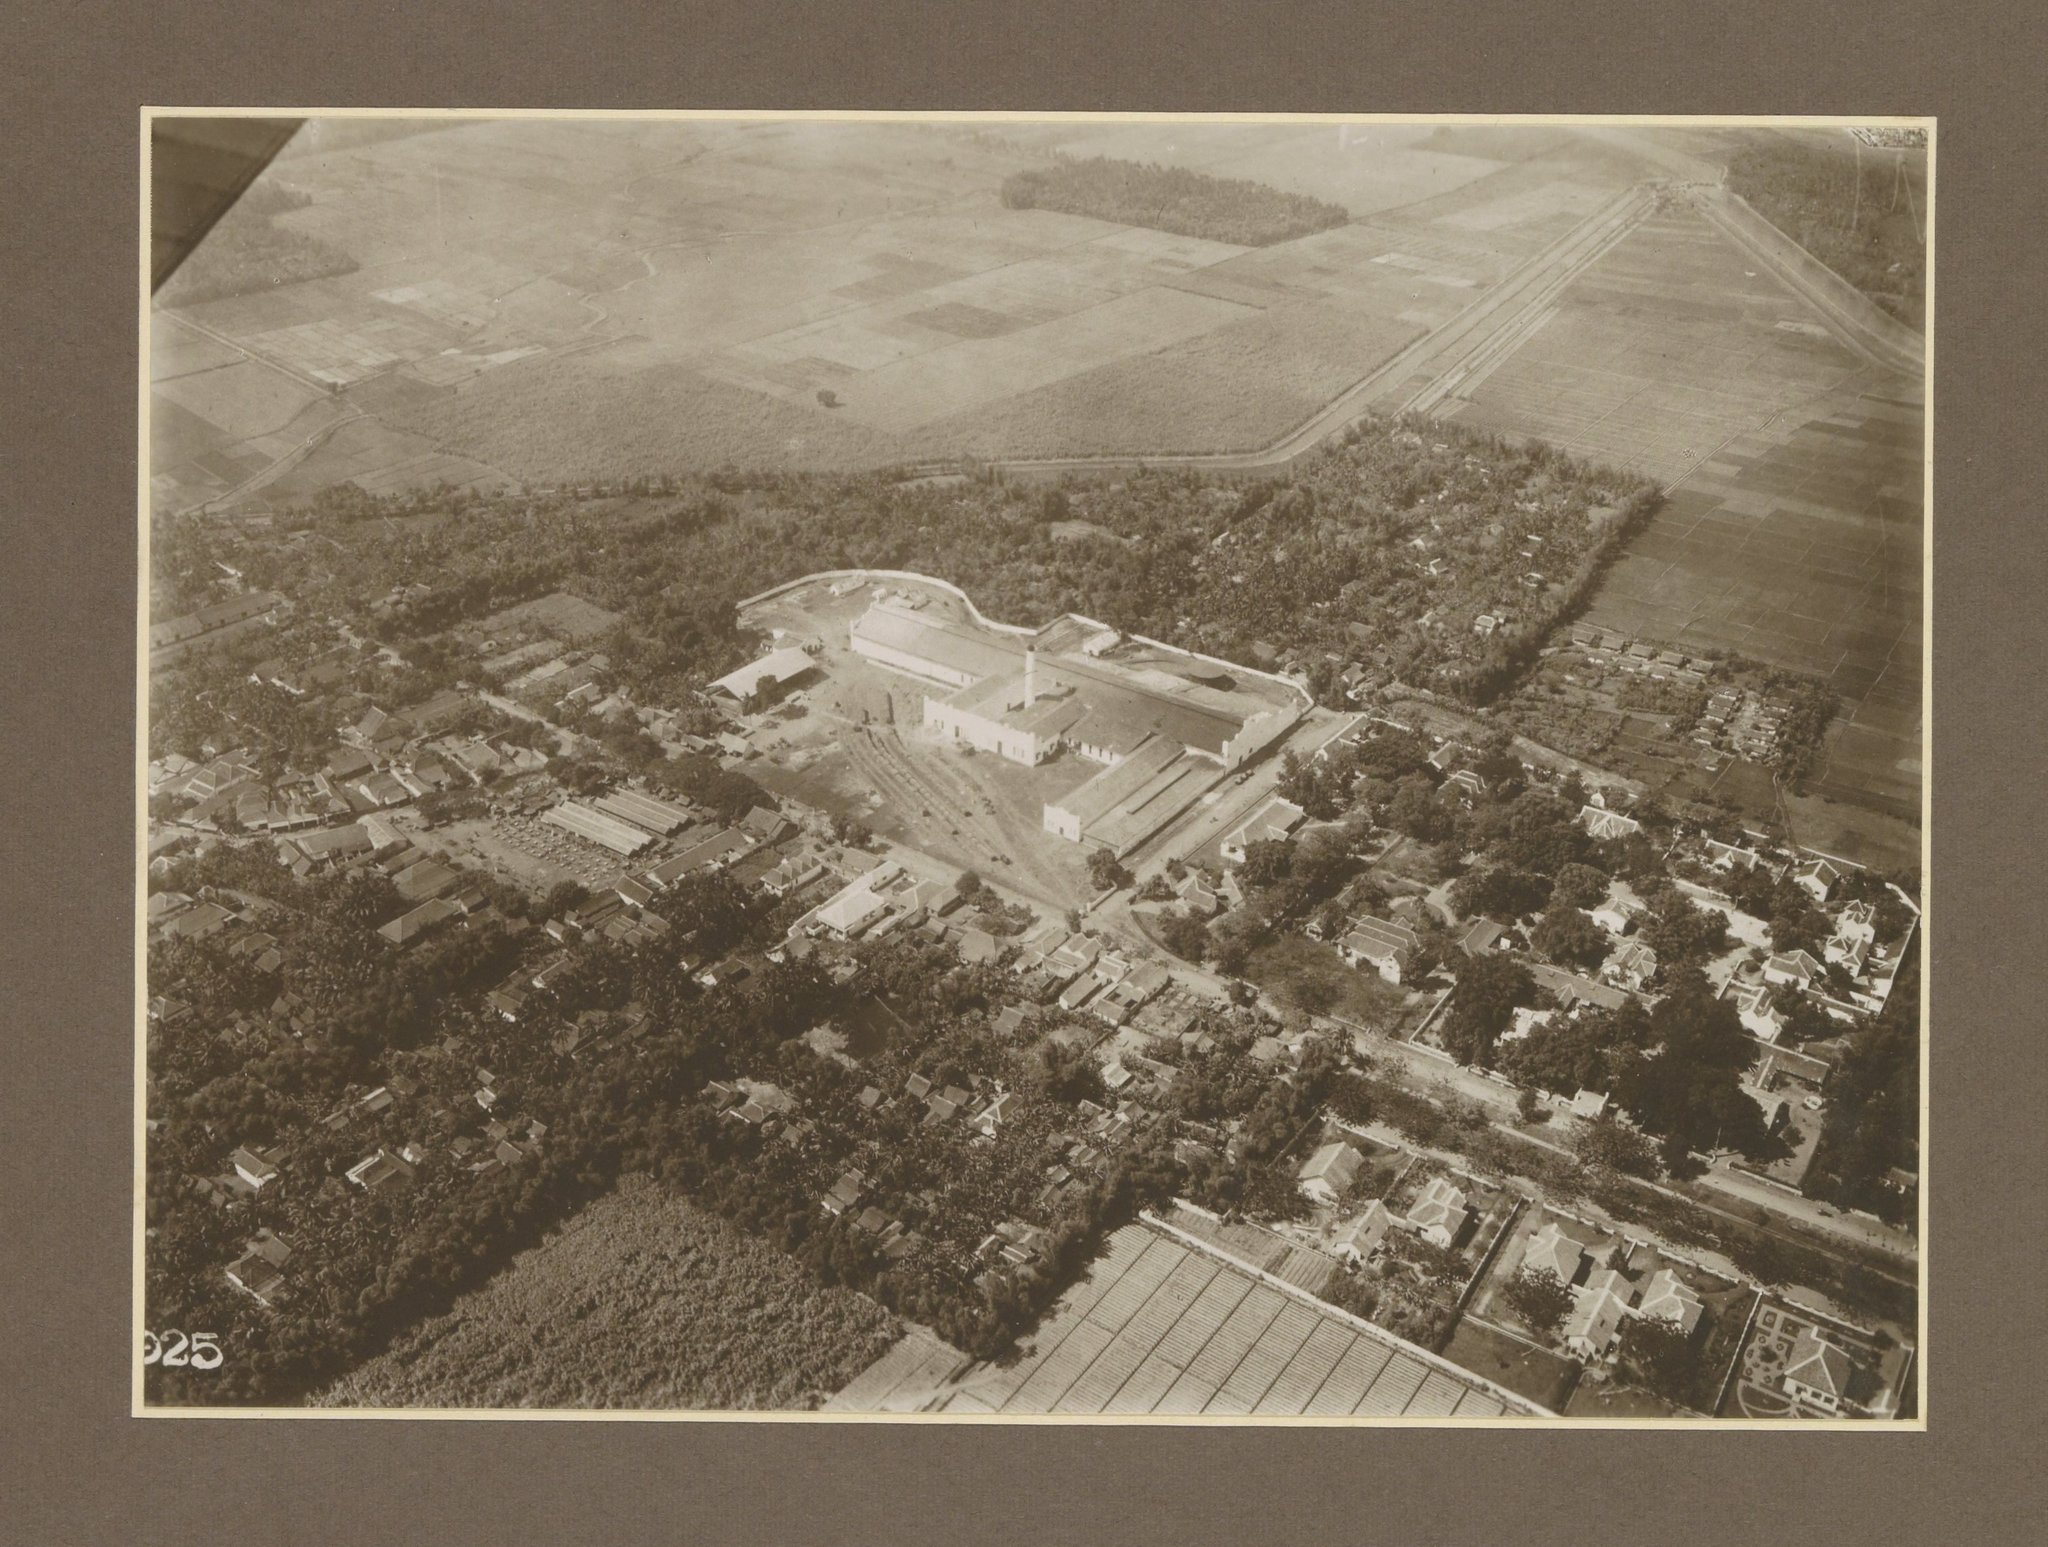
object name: aerial photograph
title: Luchtaanzicht van suikerfabriek Goedo te Djombang op Java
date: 1925-1930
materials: cardboard, paper, photographic support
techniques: gelatin silver print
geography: jombang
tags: plantation, factory in landscape, plants and herbs: sugarcane, sugar, dutch east indies, the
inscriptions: number: ‘925’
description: Onderdeel van Fotoalbum met opnames van vier suikerfabrieken op Java.